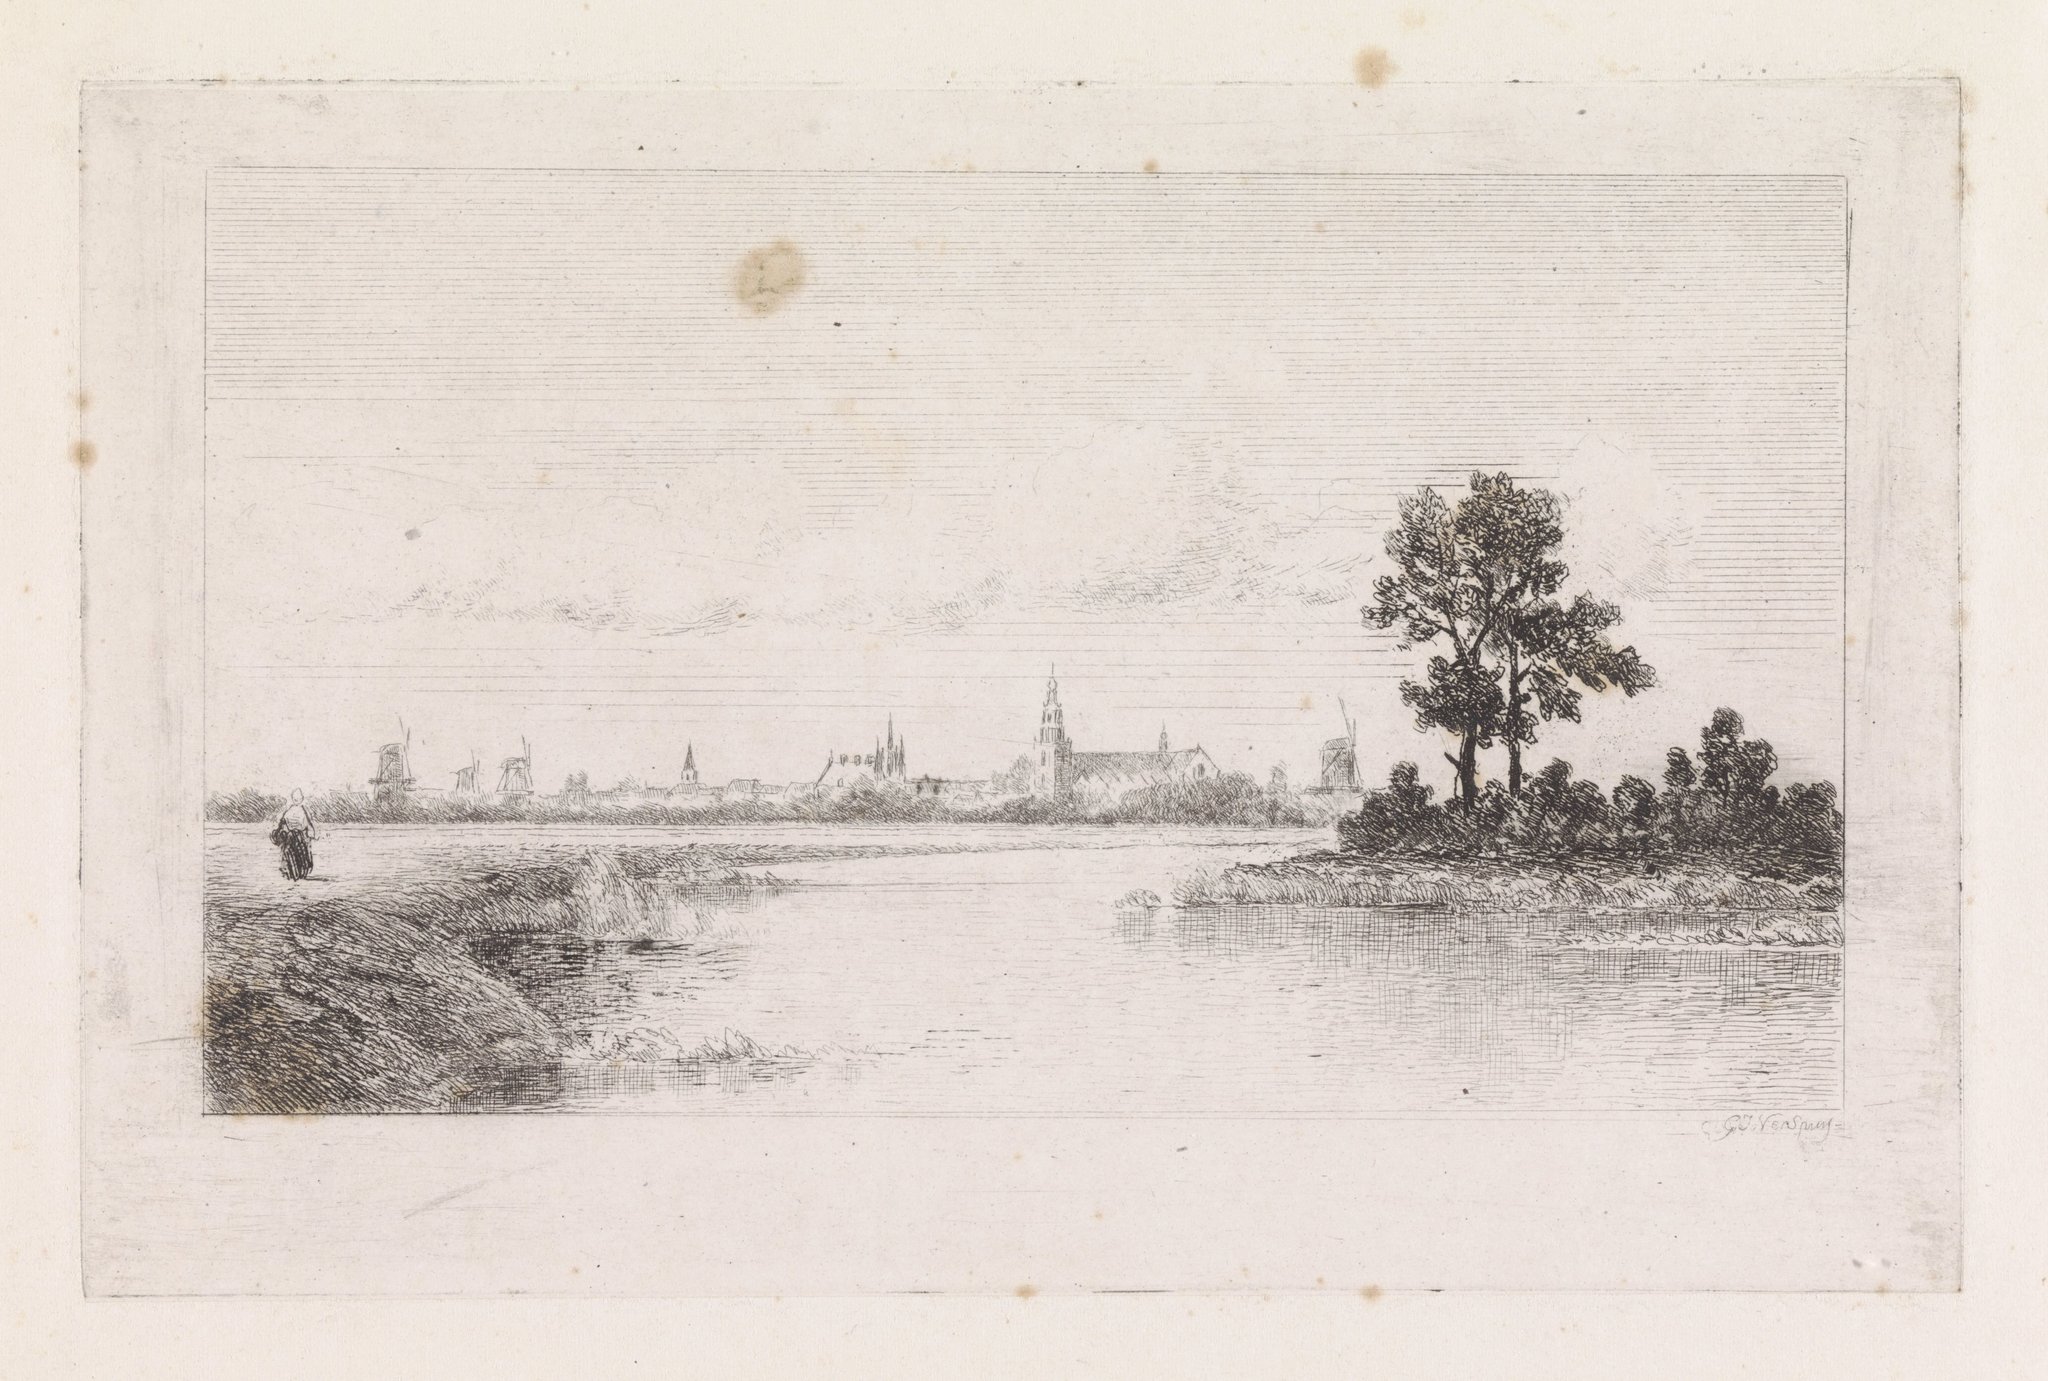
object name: print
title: Rivierlandschap met stadsprofiel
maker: gijsbertus johannes verspuy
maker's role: print maker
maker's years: 1823-1862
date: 1833-1862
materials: paper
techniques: etching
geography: netherlands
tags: river, prospect of city, town panorama, silhouette of city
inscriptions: collector's mark: Lugt 1485, collector's mark: Lugt 2228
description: Gezicht op een rivier met aan de horizon een stad. Links een vrouwenfiguur op de oever.